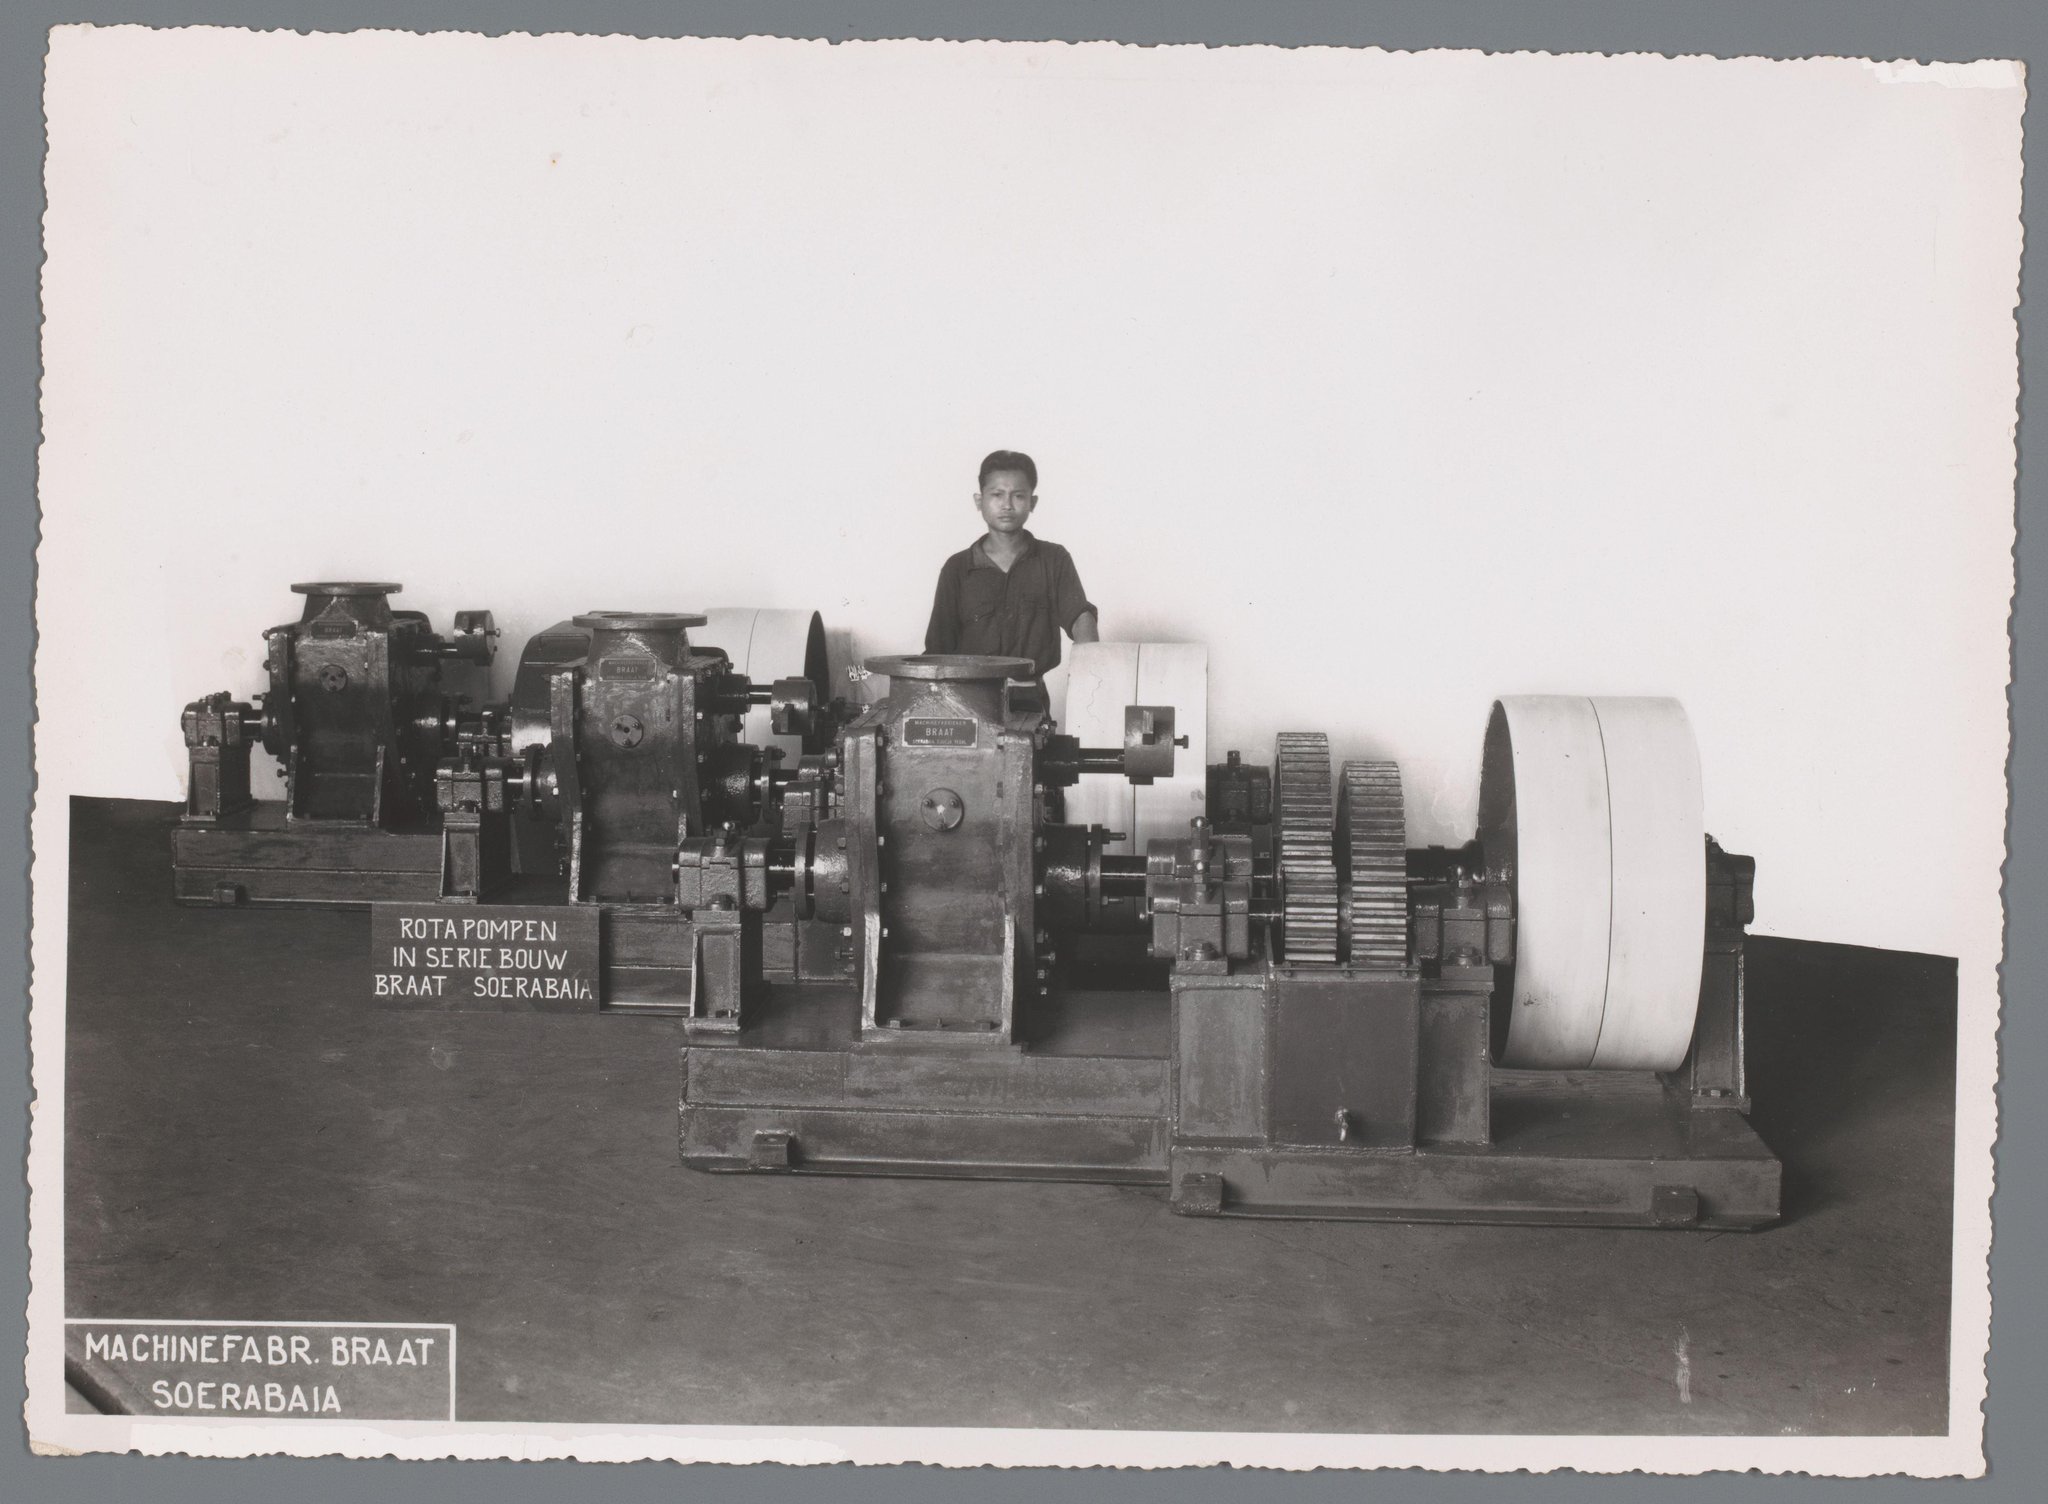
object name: photograph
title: Rotapompen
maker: Anonymous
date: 1937-1938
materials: photographic support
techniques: gelatin silver print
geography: surabaya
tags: colonial system, machines; parts of machines; tools and appliances, factory-interior, machine shop (+ men (labourers)), java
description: Rotapompen voor massacuite, vervaardigd ca. 1937-1938 en waarschijnlijk bestemd voor de suikerindustrie. Onderdeel van de multomap met foto's van machines van de N.V. Machinefabriek Braat te Soerabaja, Soekaboemi en Jogyakarta, uit de periode 1908-1942.